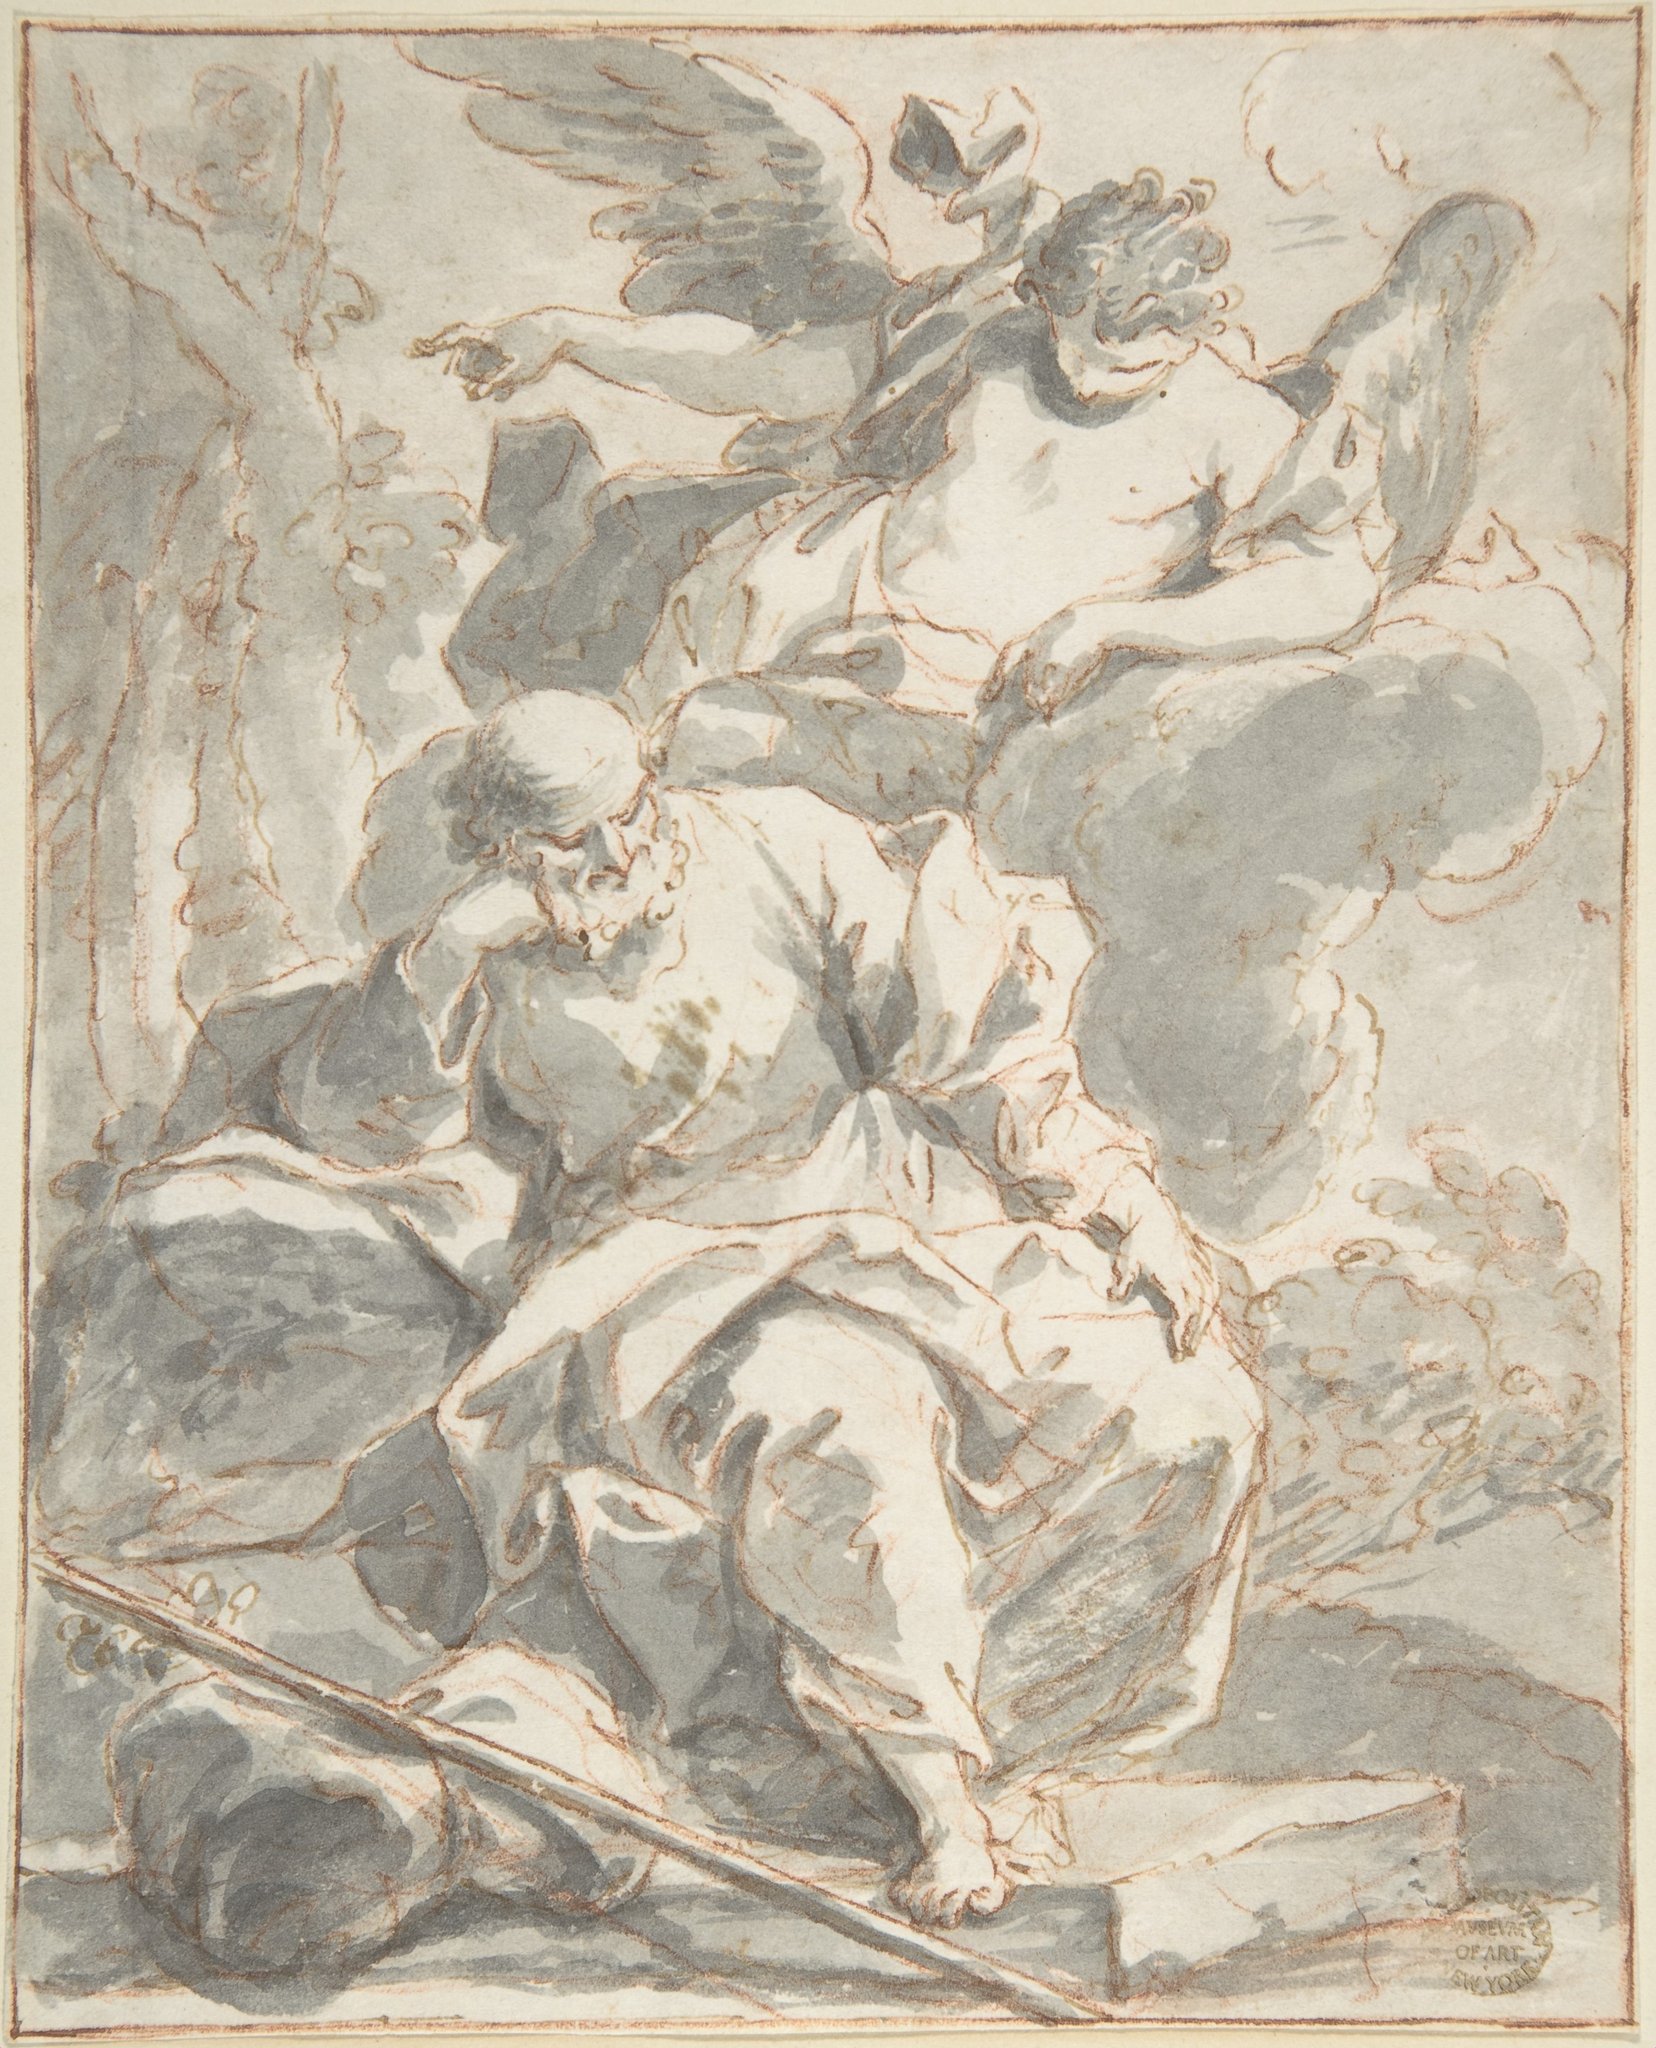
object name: drawing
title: Angel Appearing to an Old Man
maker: anonymous, italian, 18th century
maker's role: artist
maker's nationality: italian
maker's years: 1700-1800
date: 1701-1800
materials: chalk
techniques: wash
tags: men,angels